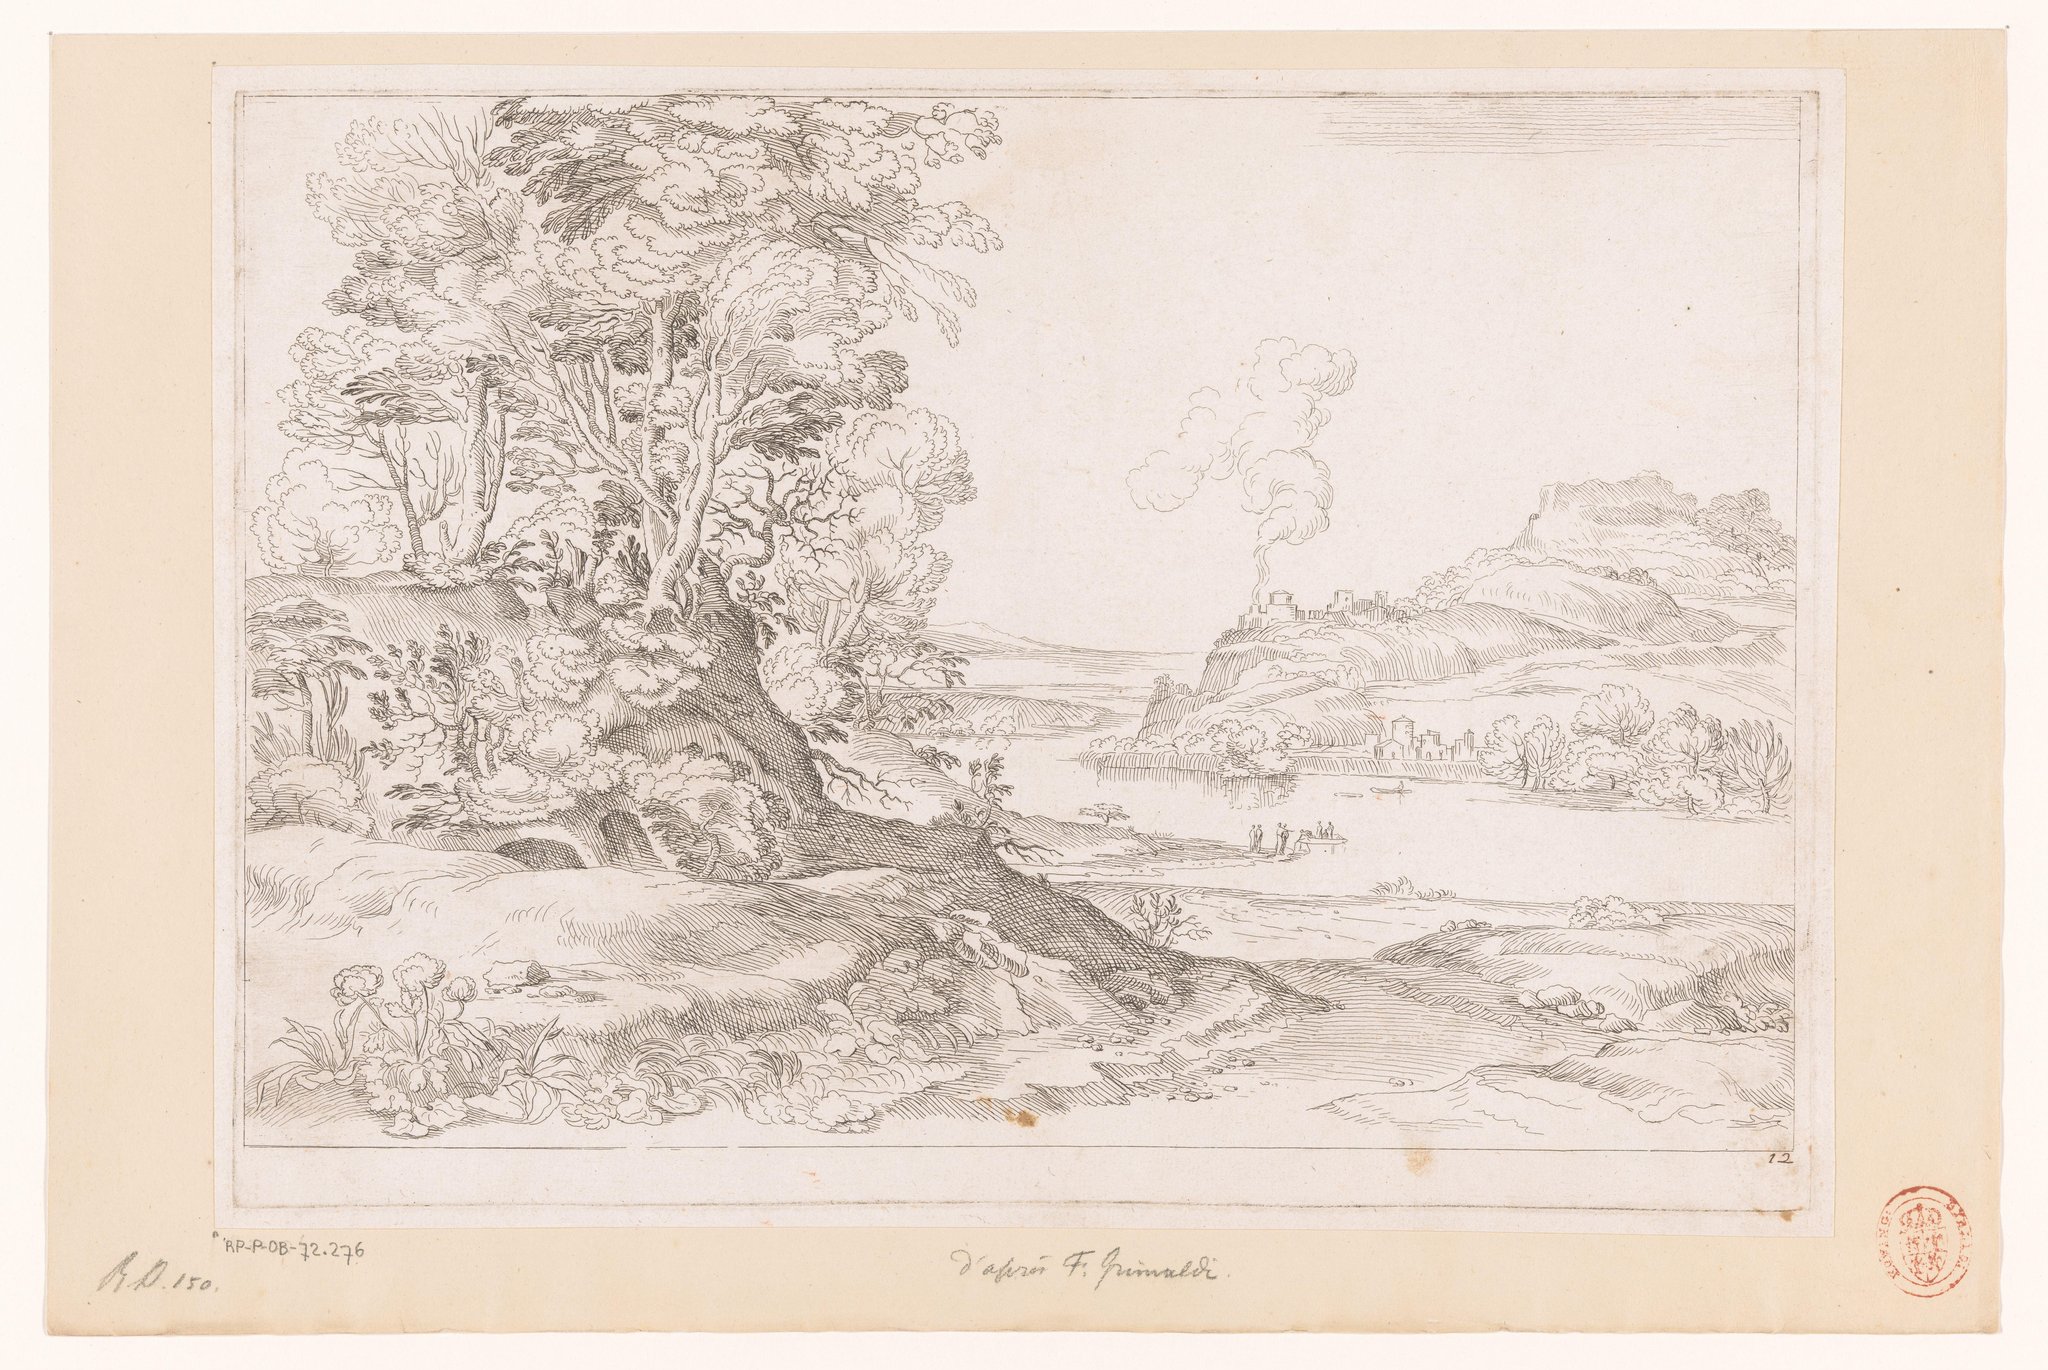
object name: print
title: Rivierlandschap met bomen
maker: jean pesne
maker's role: print maker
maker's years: 1623-1700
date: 1666-1695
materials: paper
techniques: etching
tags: trees, river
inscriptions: collector's mark: Lugt 240, number: ‘12’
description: Prent maakt deel uit van een serie van 283 prenten, ongenummerde staat.